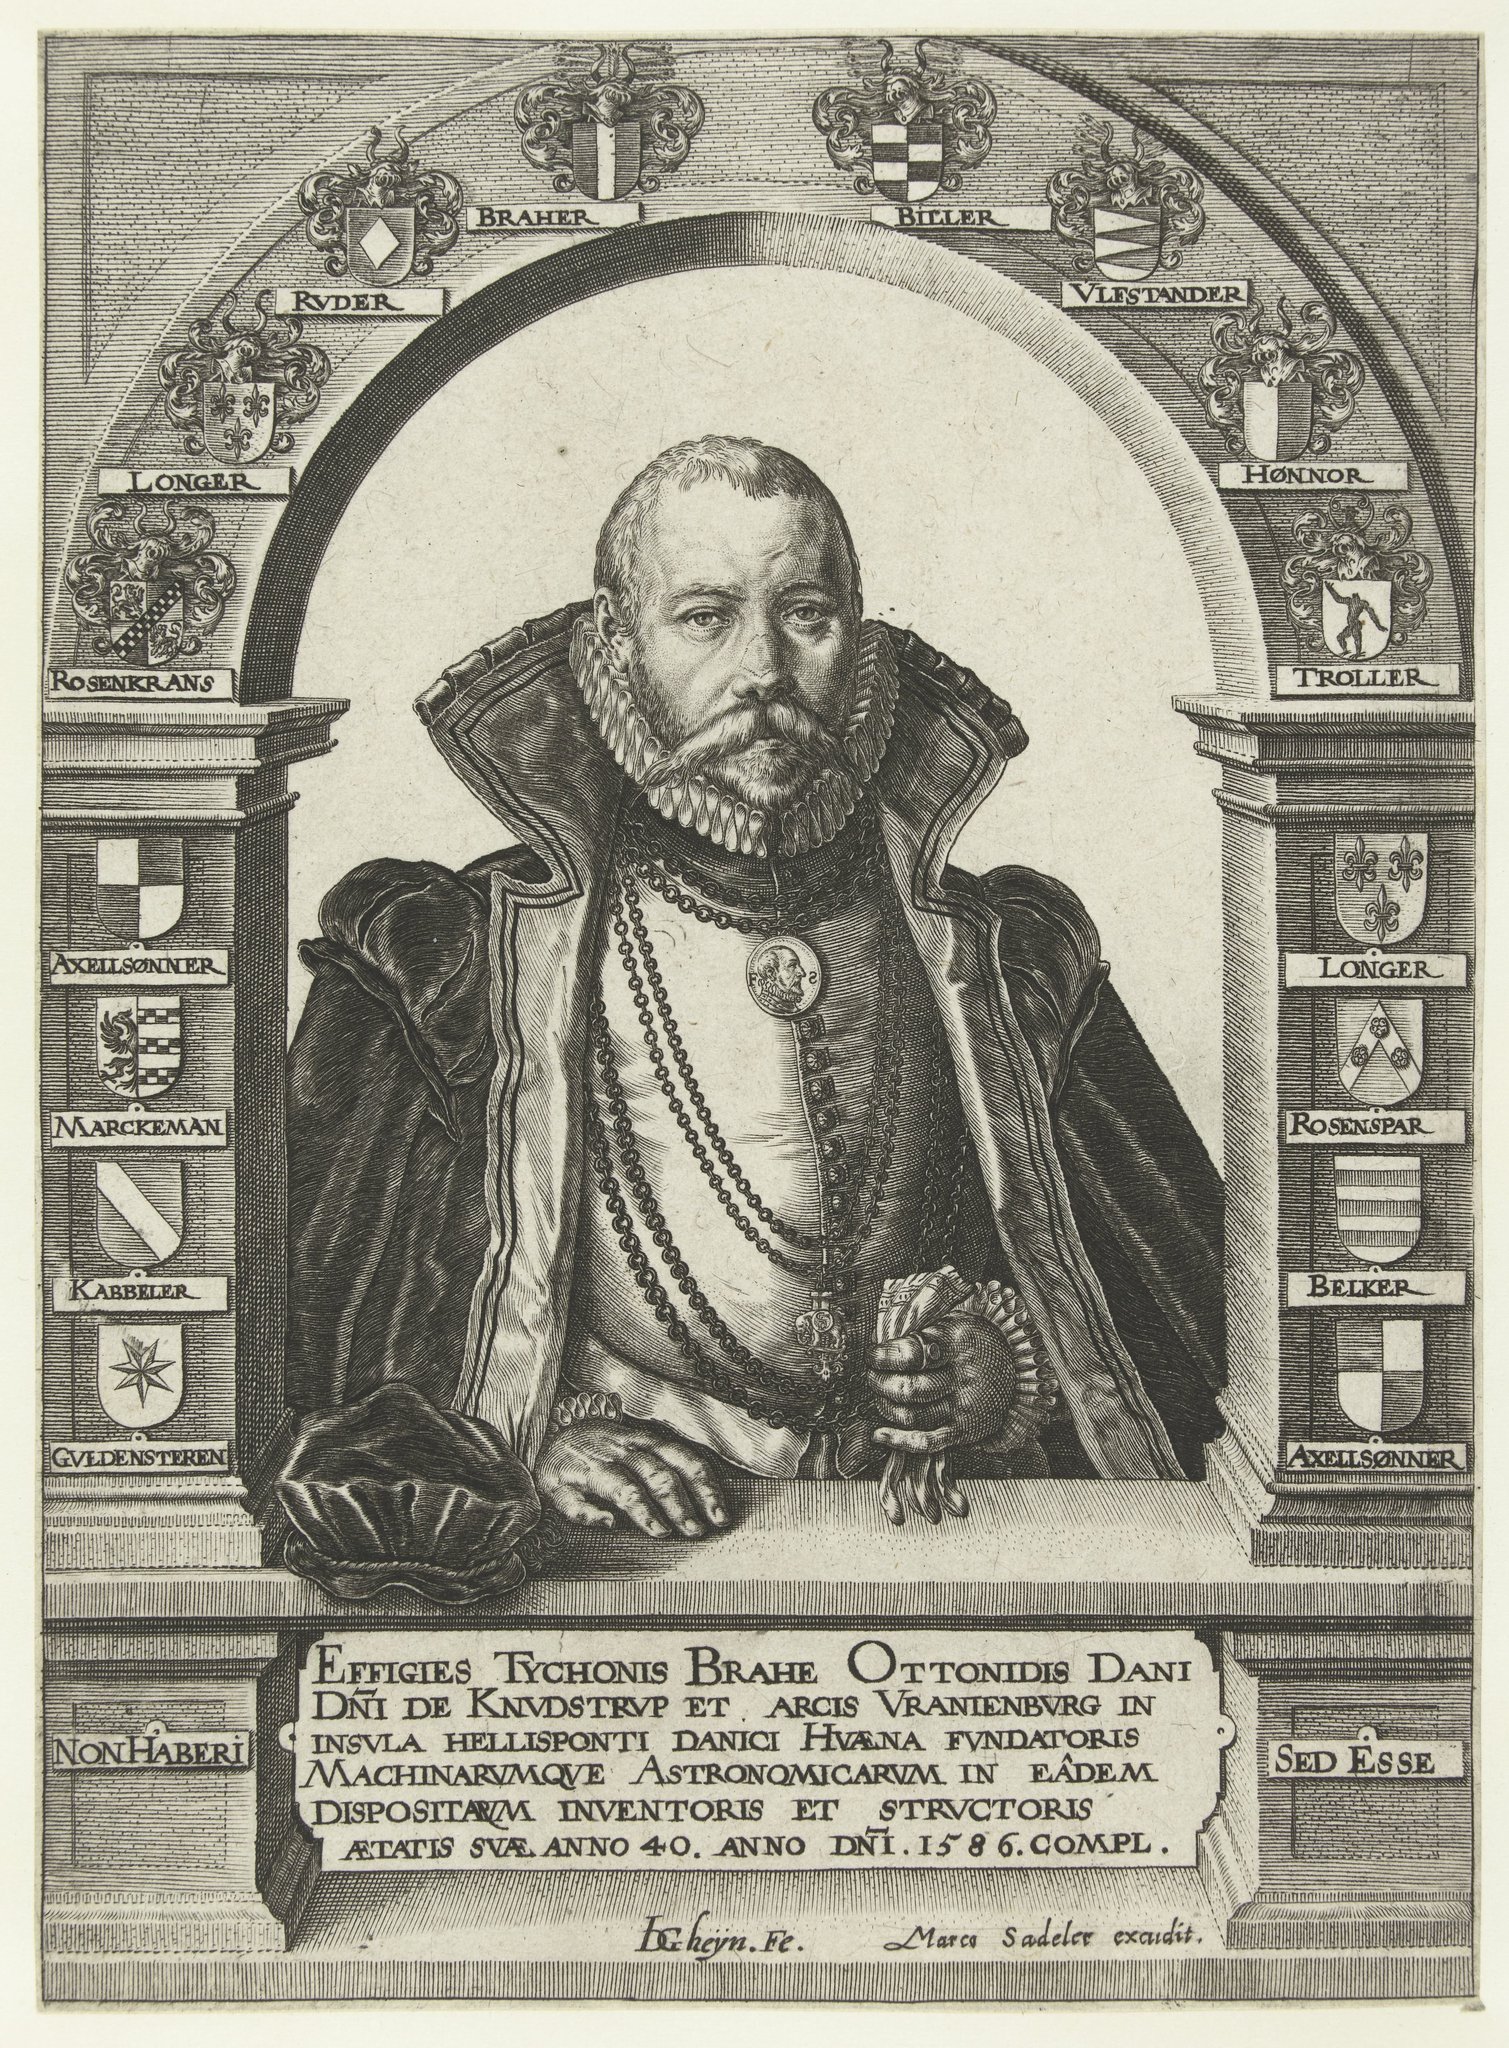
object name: print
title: Portret van Tycho Brahe op veertigjarige leeftijd (zonder muts)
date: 1593-1597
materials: paper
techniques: engraving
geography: germany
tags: prague, tycho brahe, head-gear, gloves, mittens, etc., coat (+ men's clothes), historical persons, armorial bearing, heraldry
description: Tycho Brahe op veertigjarige leeftijd, ten halven lijve, van voren gezien, in een boogvormige nis, gekleed in mantel met opstaande kraag, waaronder een geplooide kraag. Kettingen om de hals, handschoen(en) in de linkerhand, muts op de vensterbank bij de rechterhand. Op de boogvormige nis verschillende wapens met familienamen erbij. Latijns onderschrift in cartouche. Aan weerszijden van de cartouche het motto 'Non Haberi Sed Esse'.